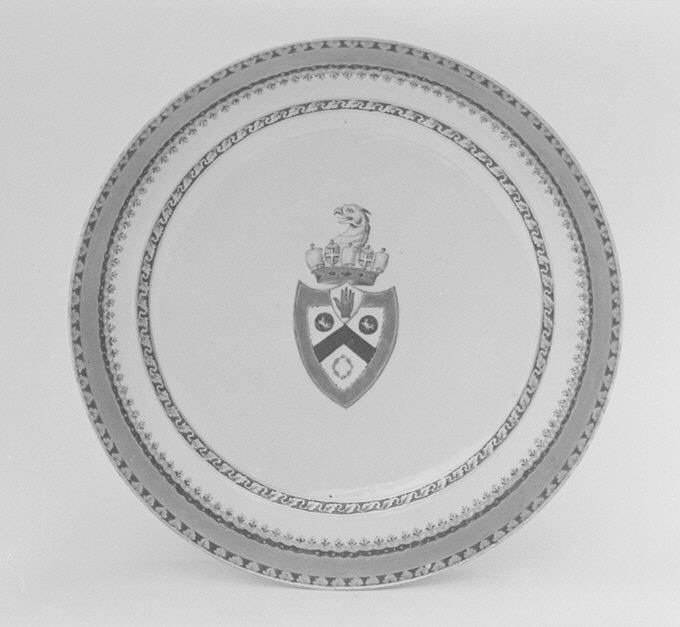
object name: dish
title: Deep dish (part of a set)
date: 1785-1800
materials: hard paste porcelain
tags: coat of arms